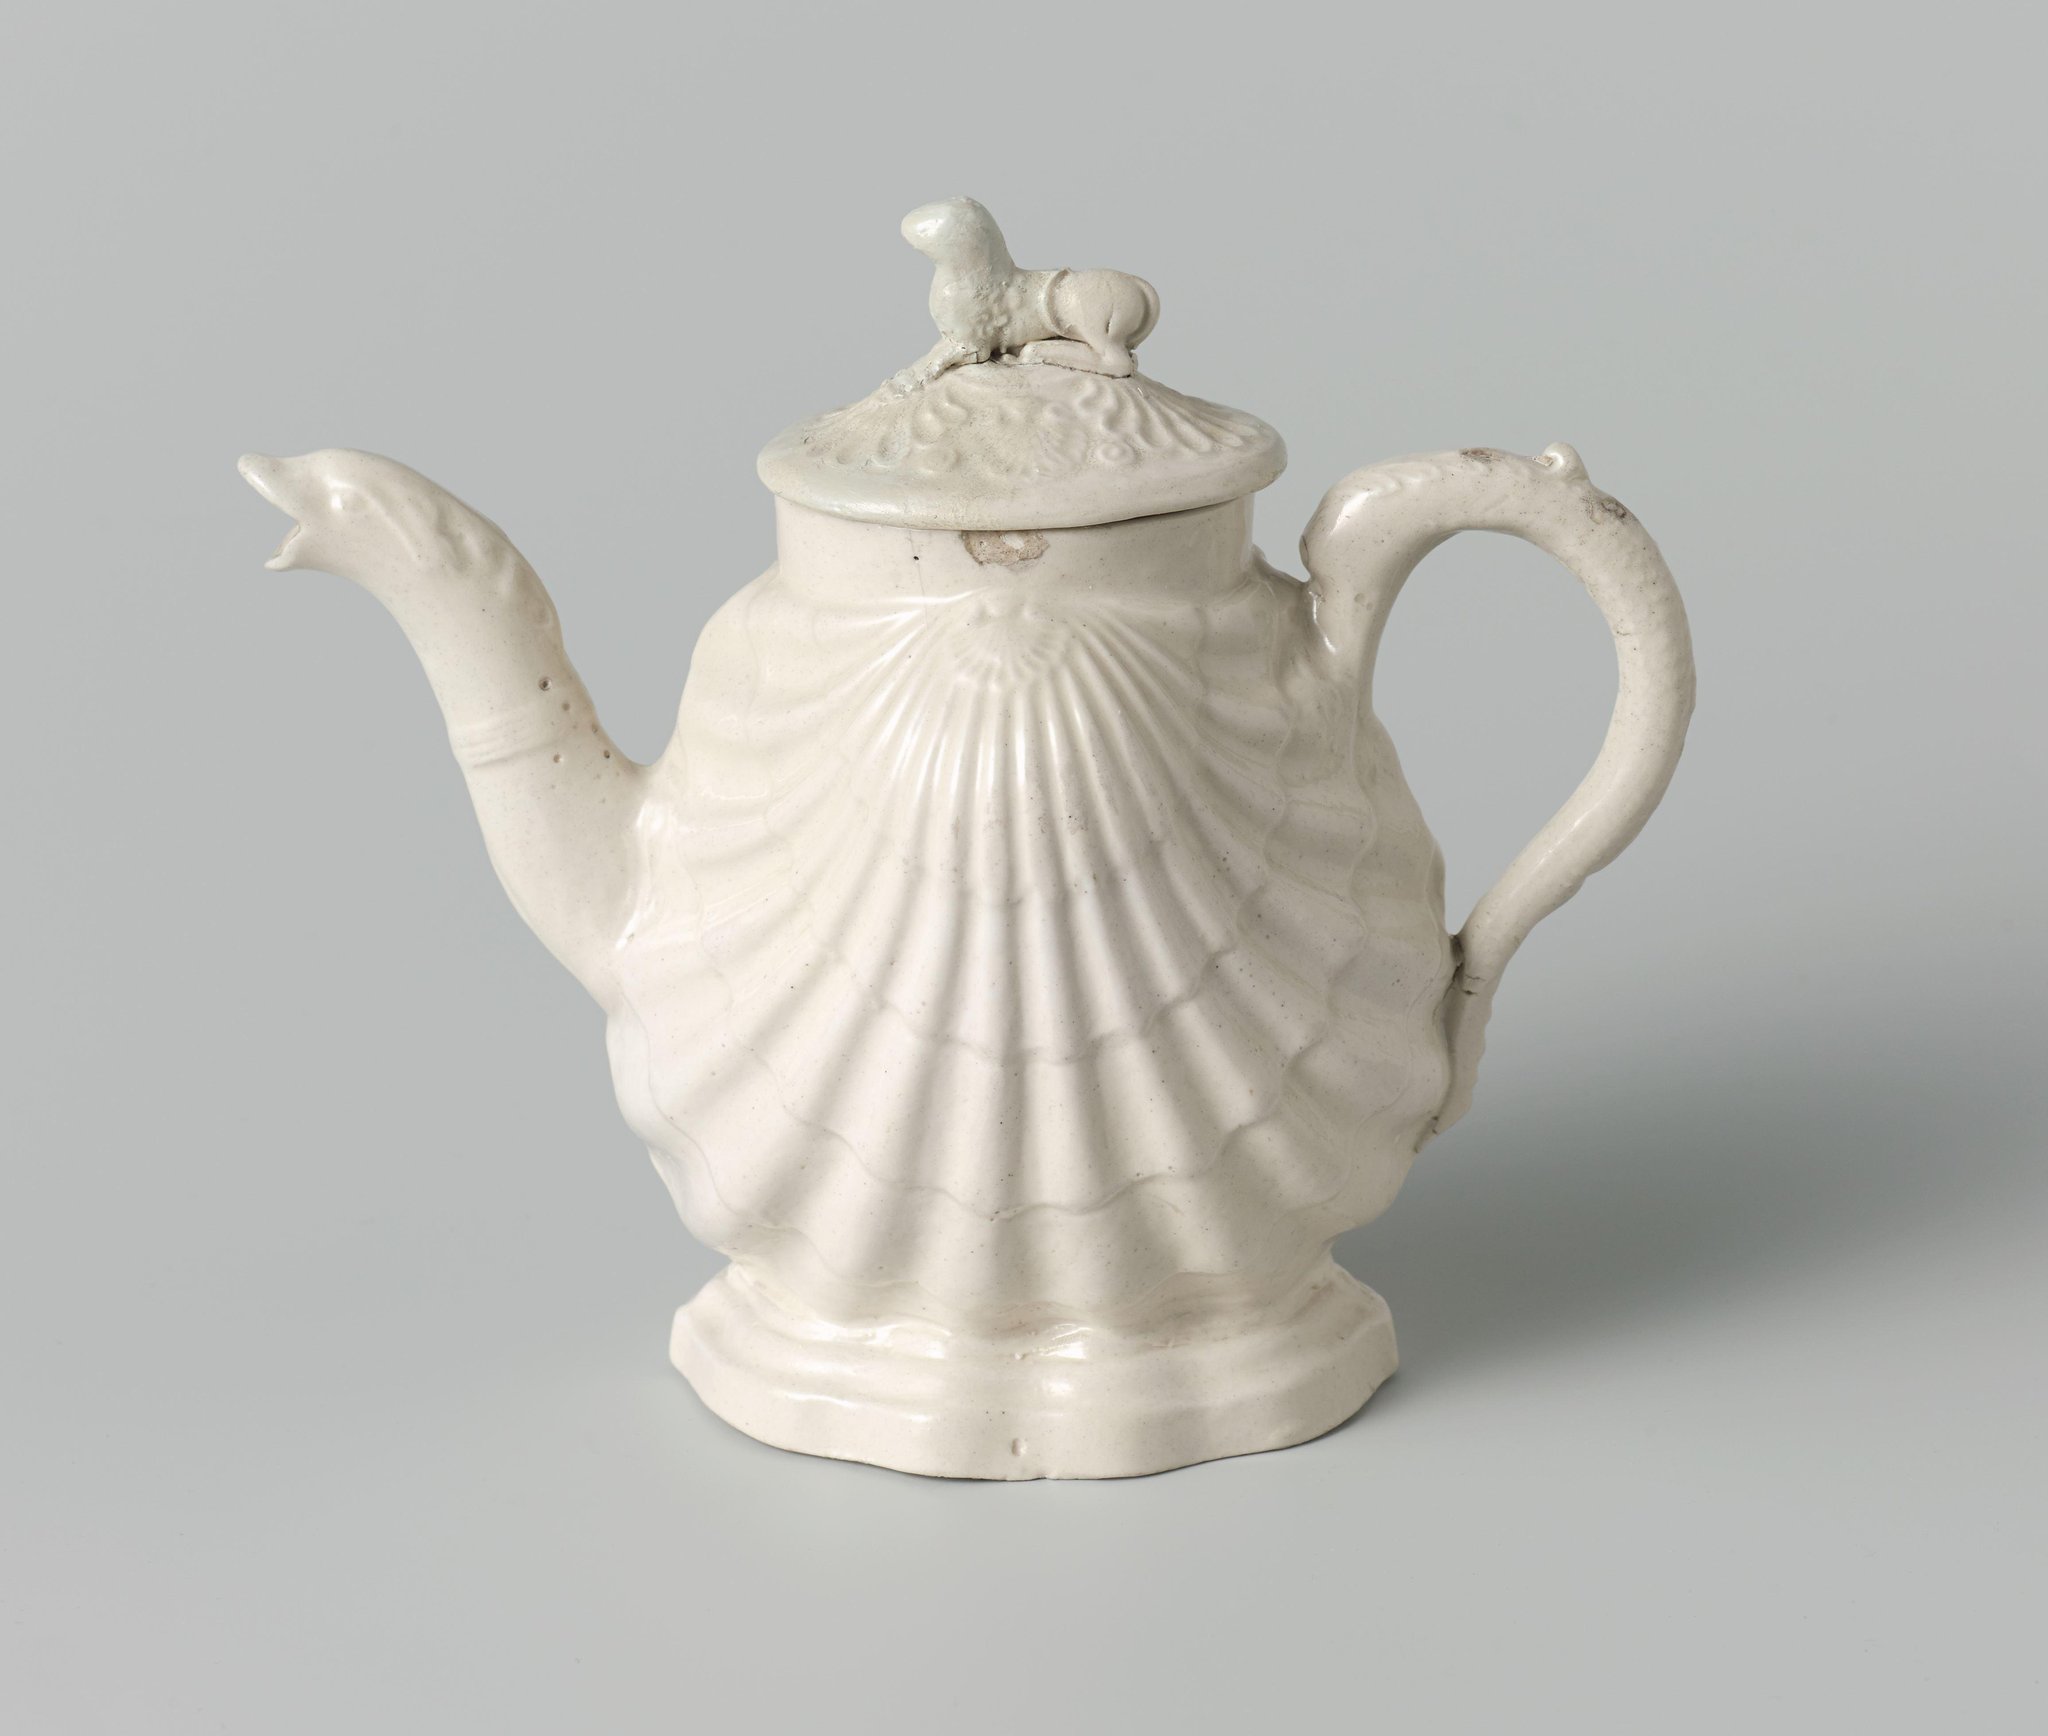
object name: teapot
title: Theepot van wit steengoed met zoutglazuur; Whieldon ware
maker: Anonymous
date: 1750-1760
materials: stoneware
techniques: salt glaze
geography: england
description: Theepot van wit steengoed met zoutglazuur. De buik van de pot heeft de vorm van een dubbele schelp. De tuit is gebogen en heeft als mond de kop van een vis. Het oor is C-vormig en heeft de vorm van een dolfijn.